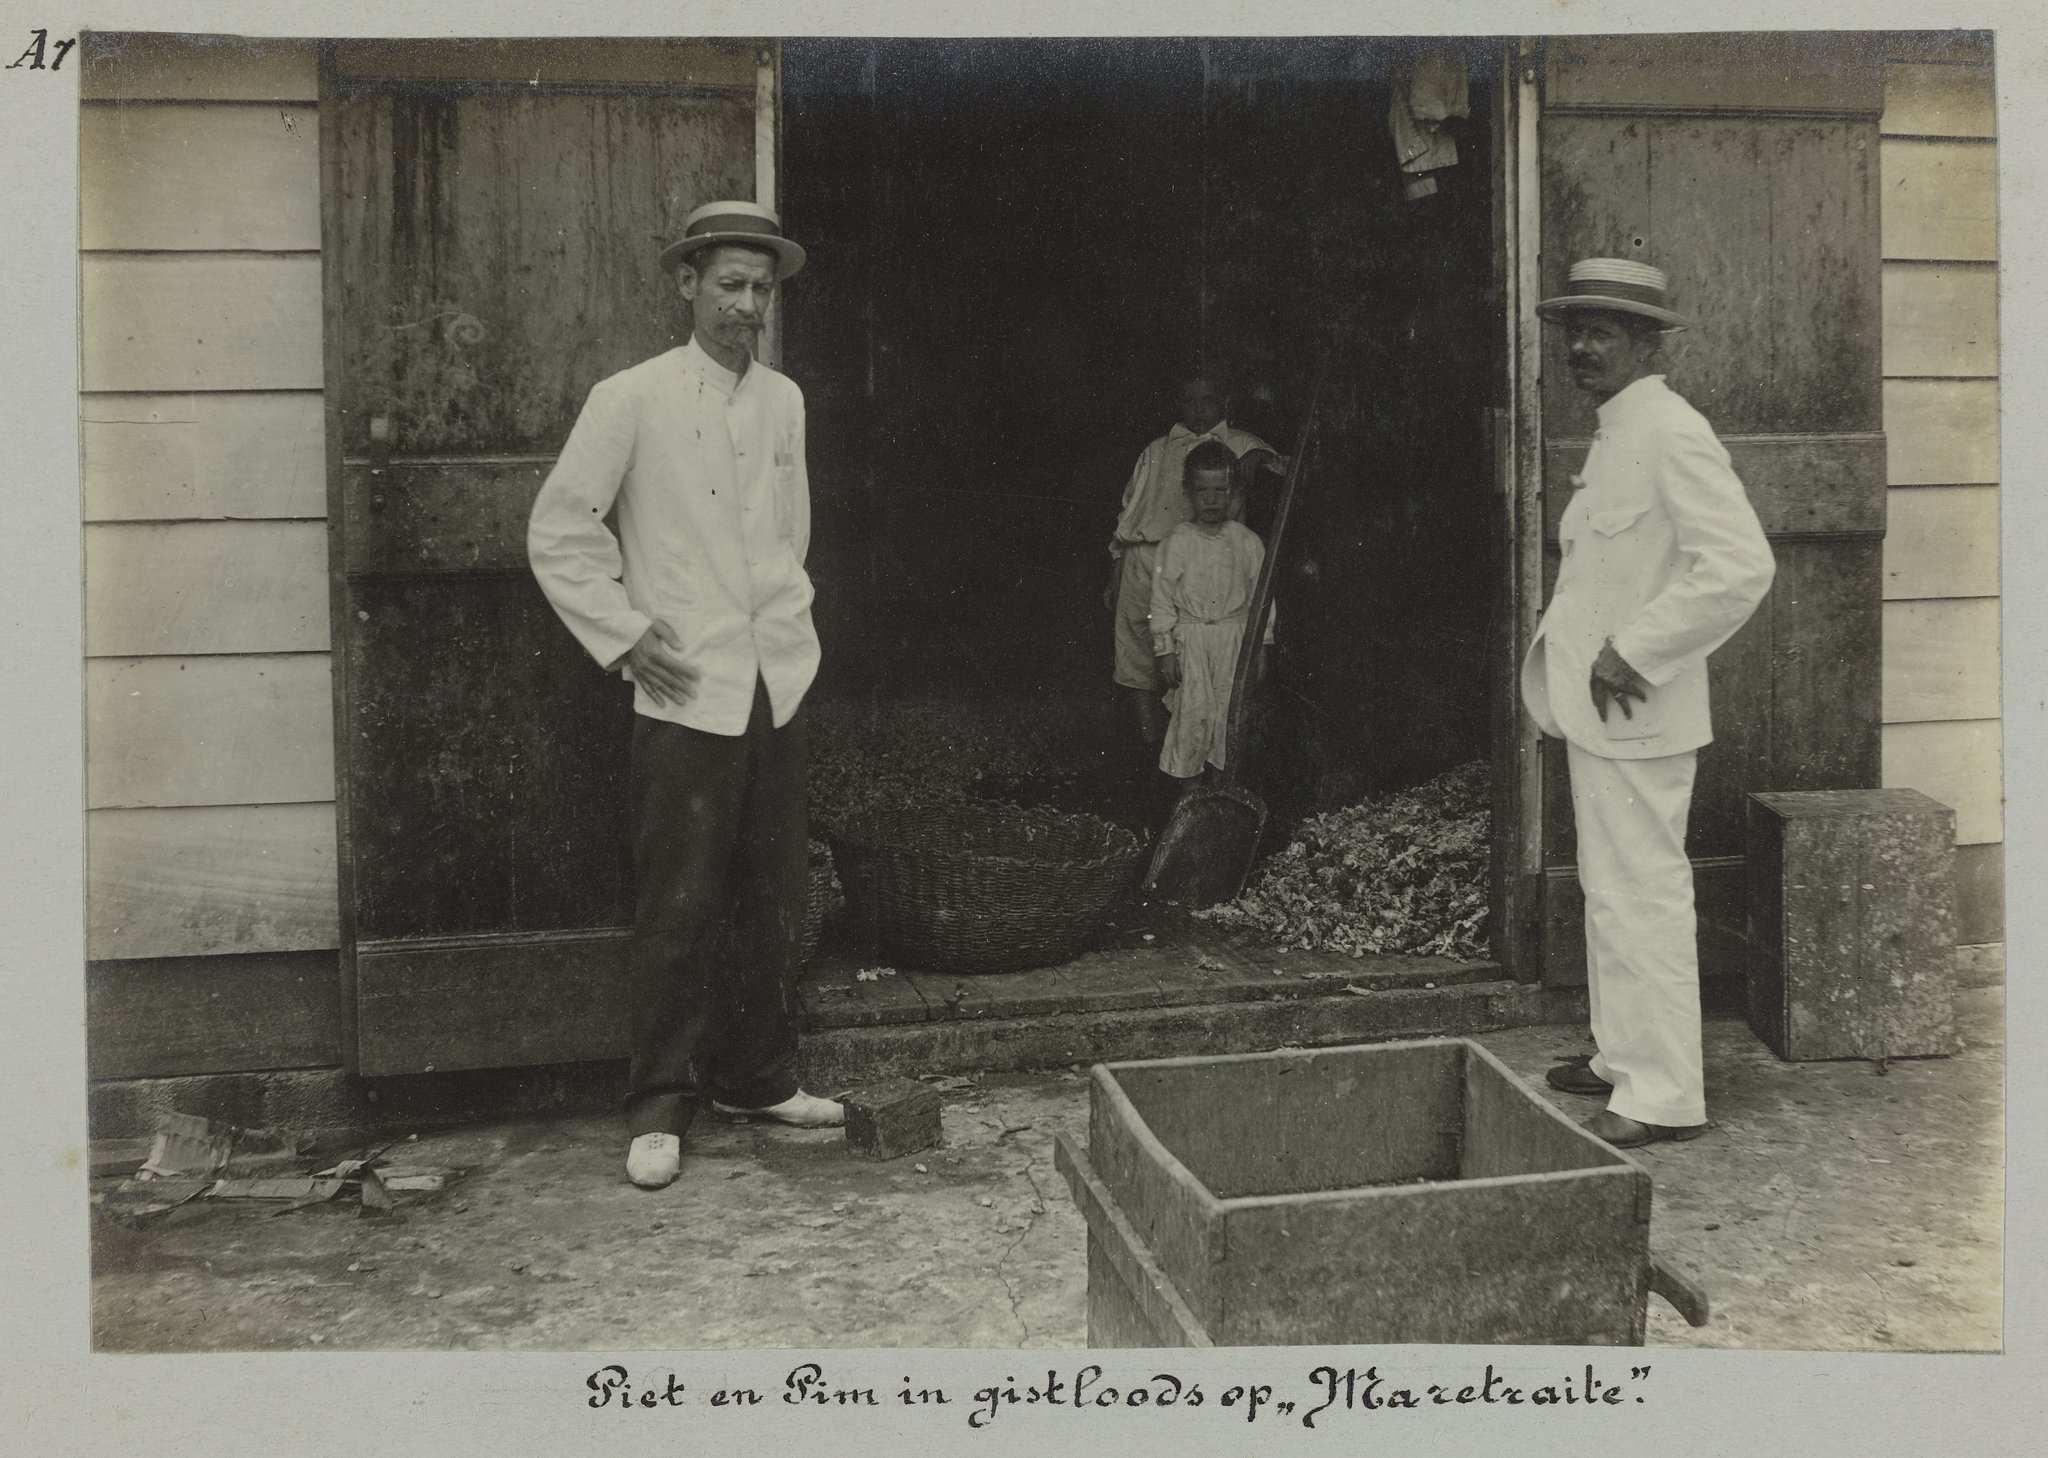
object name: photograph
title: Piet en Pim in gistloods op "Ma retraite"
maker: hendrik doijer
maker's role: engineer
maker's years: 1863-1925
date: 1903-1910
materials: photographic support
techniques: gelatin silver print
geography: suriname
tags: suriname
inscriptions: inscription: ‘A7 / Piet en Pim in gistloods op "Ma retraite".’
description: Twee Nederlandse mannen staande voor de ingang van een gistloods (cacaocultuur) op de plantage Ma Retraite. In de schuur twee staande Nederlandse jongens. De mannen of de jongens zijn genaamd Piet en Pim. Onderdeel van het fotoalbum Souvenir de Voyage (deel 1), over het leven van de familie Doijer in en rond de plantage Ma Retraite in Suriname in de jaren 1903-1910.